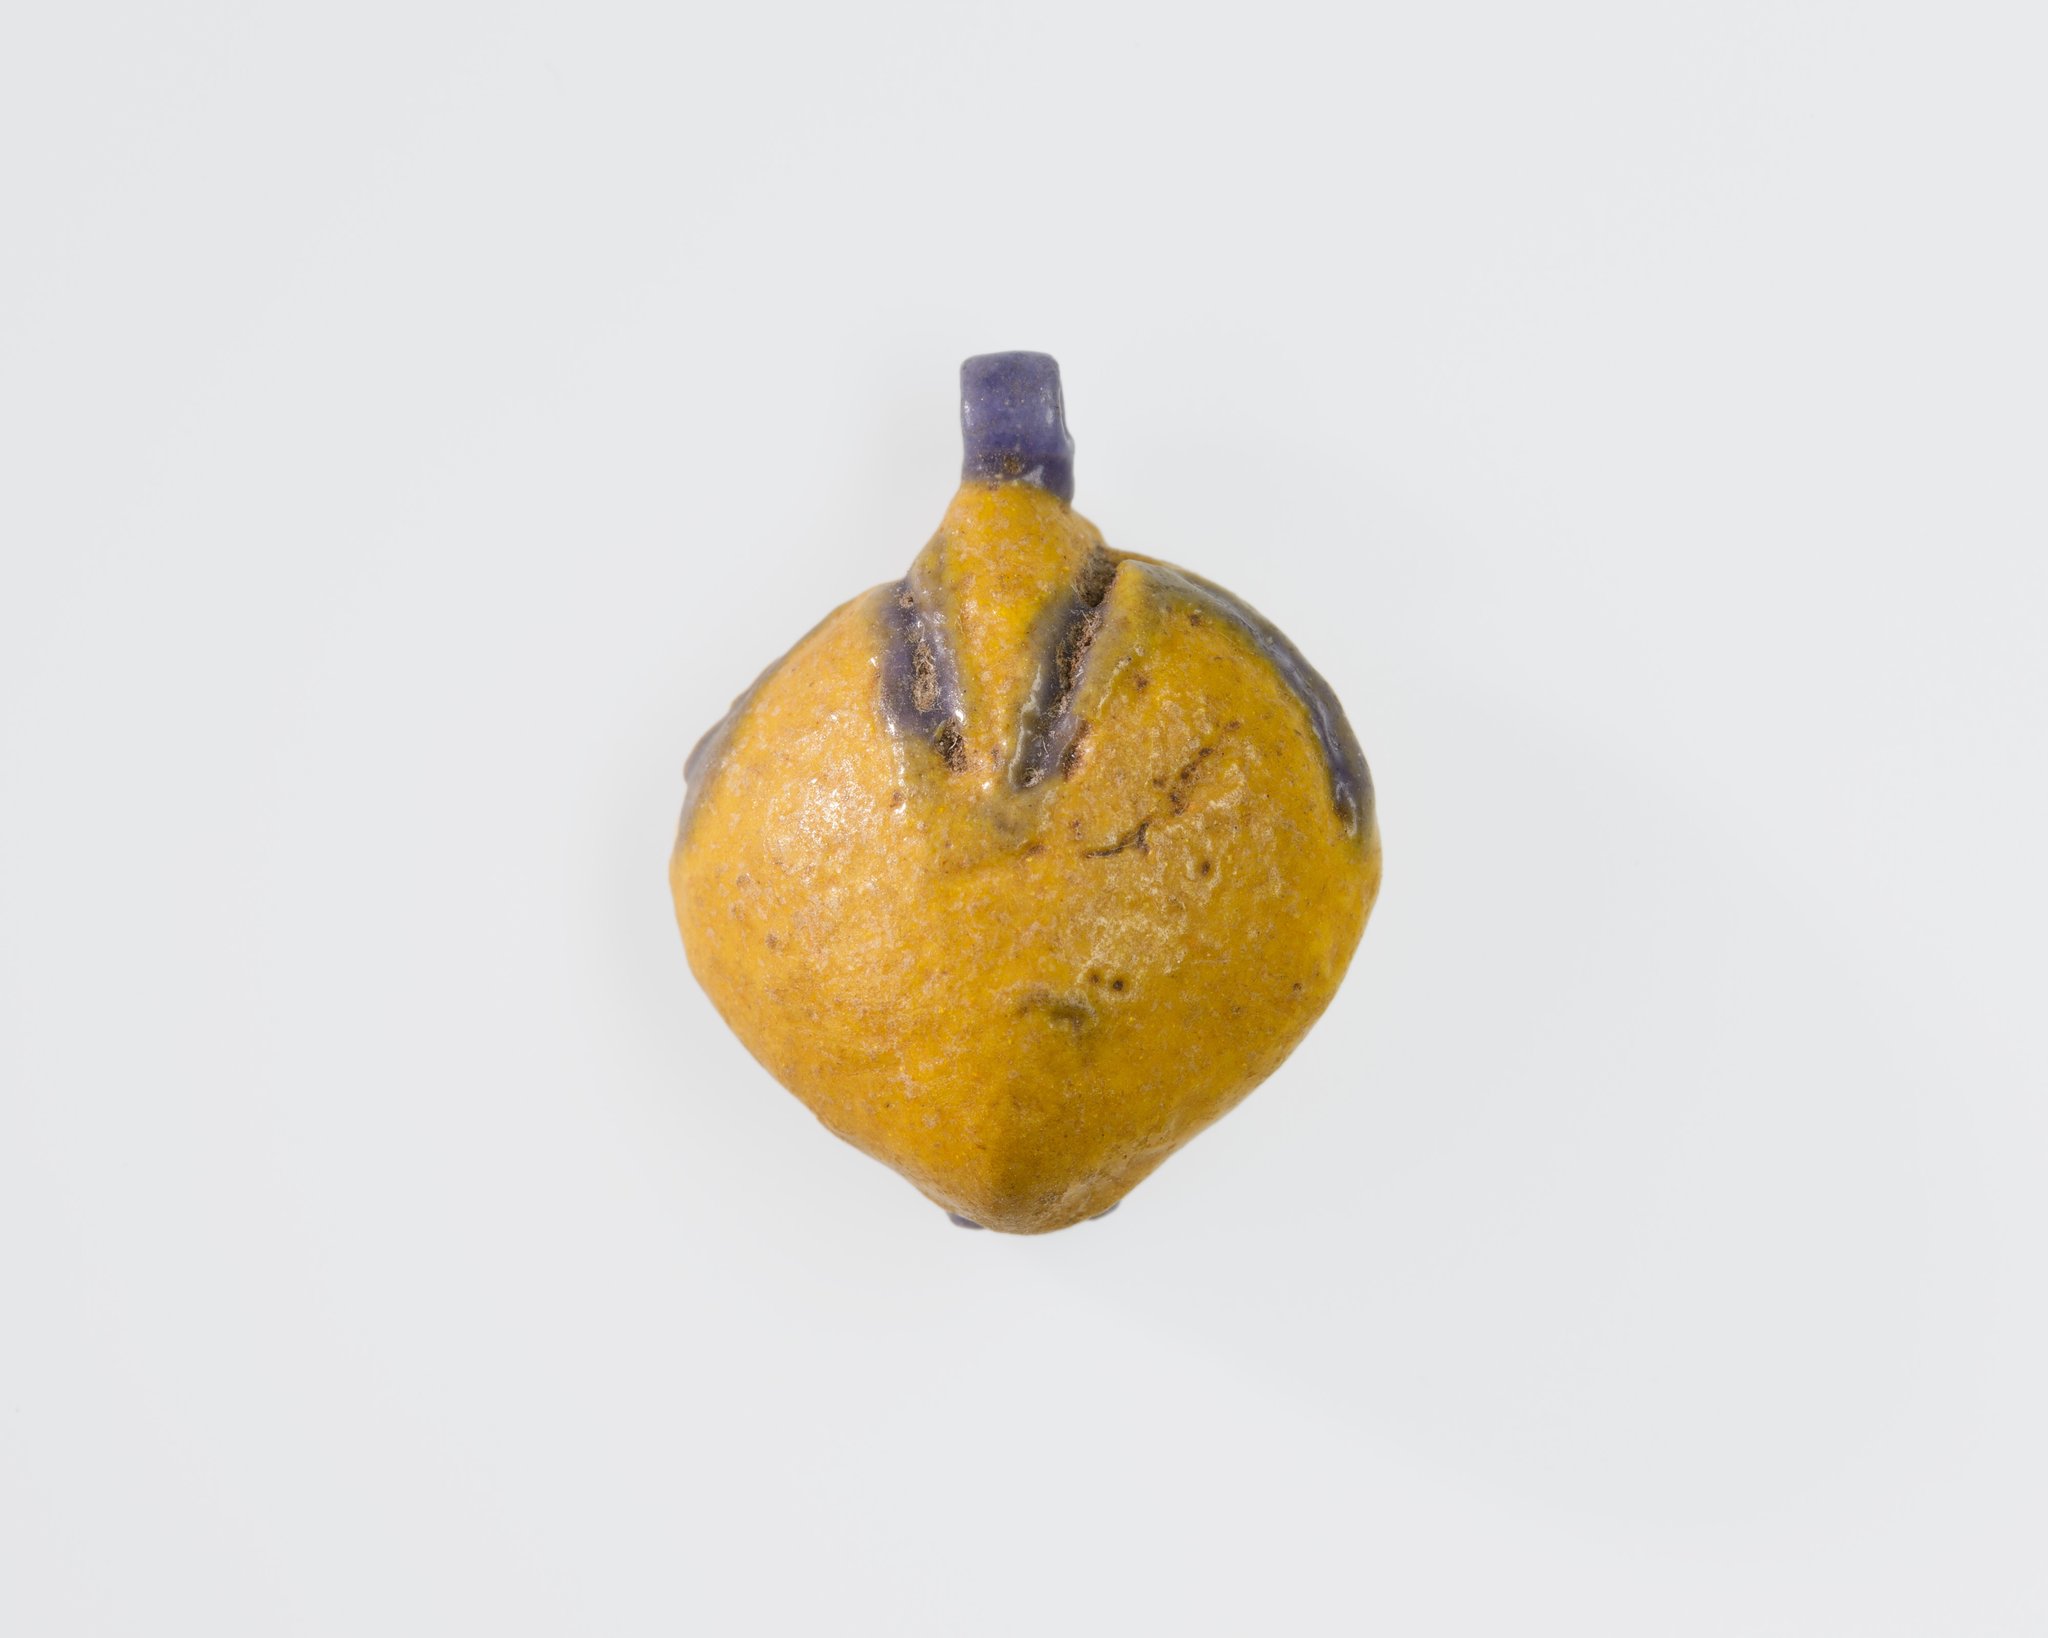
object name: pendant, persea fruit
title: Persea fruit pendant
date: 1390-1352 BCE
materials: faience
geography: egypt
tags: fruit